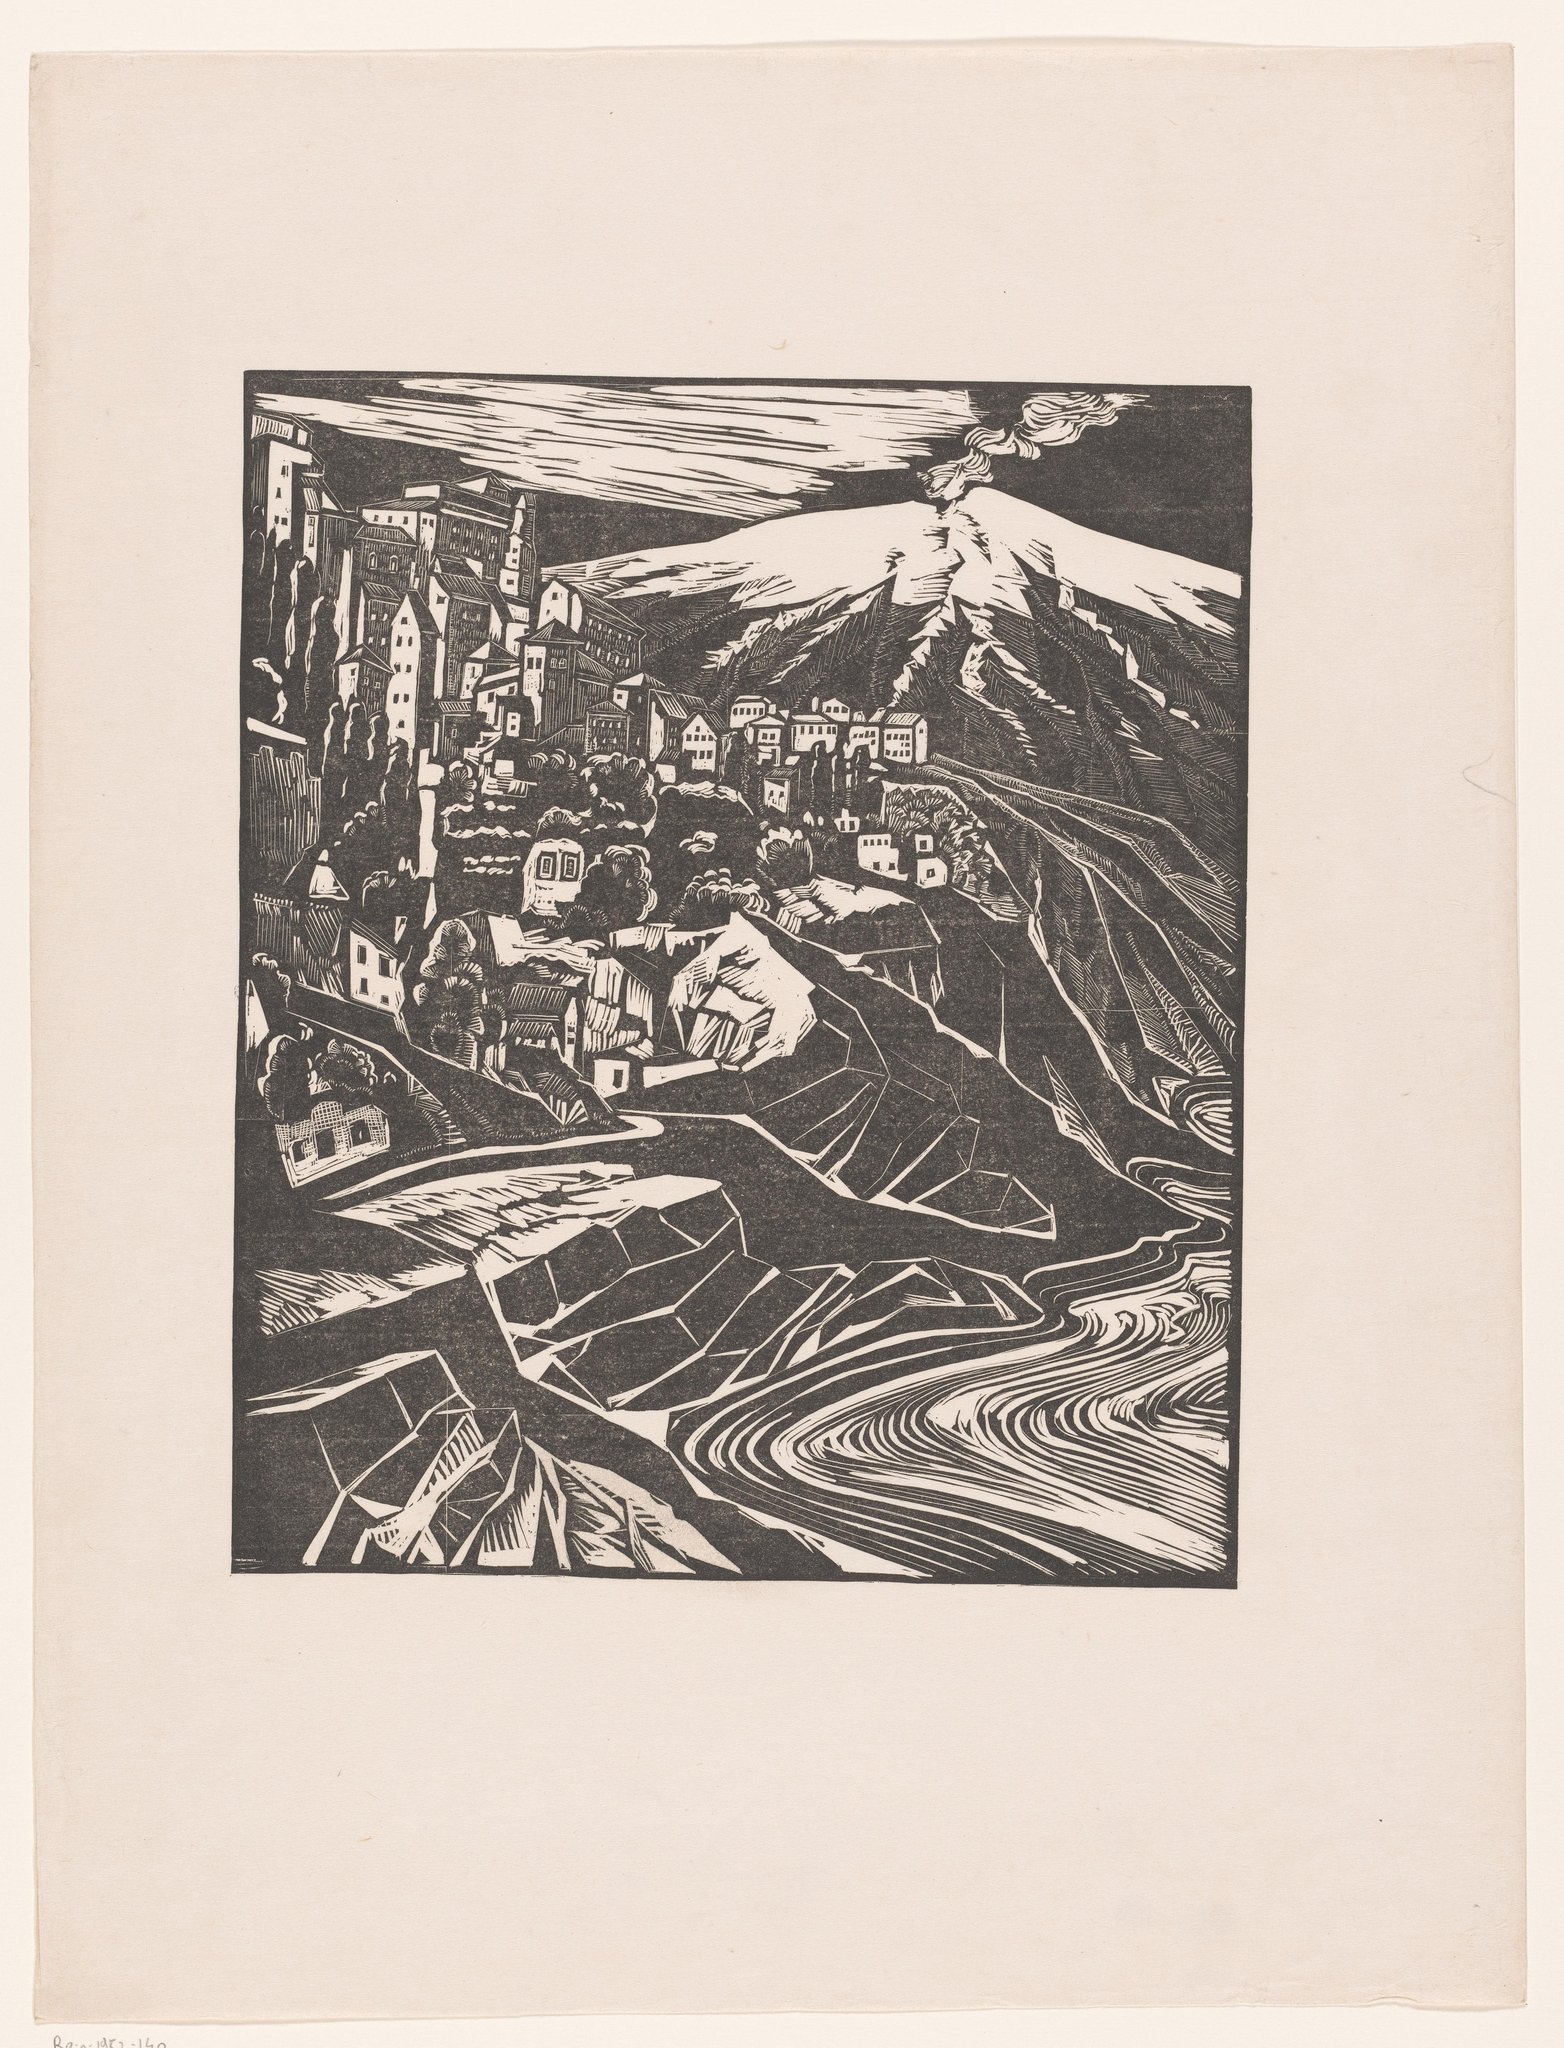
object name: print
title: Gezicht op de Etna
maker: jacobus gerardus veldheer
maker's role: draughtsman, print maker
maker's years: 1866-1954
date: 1876-1952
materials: paper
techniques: woodcut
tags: rocky coast, volcano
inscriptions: collector's mark: Lugt 2228